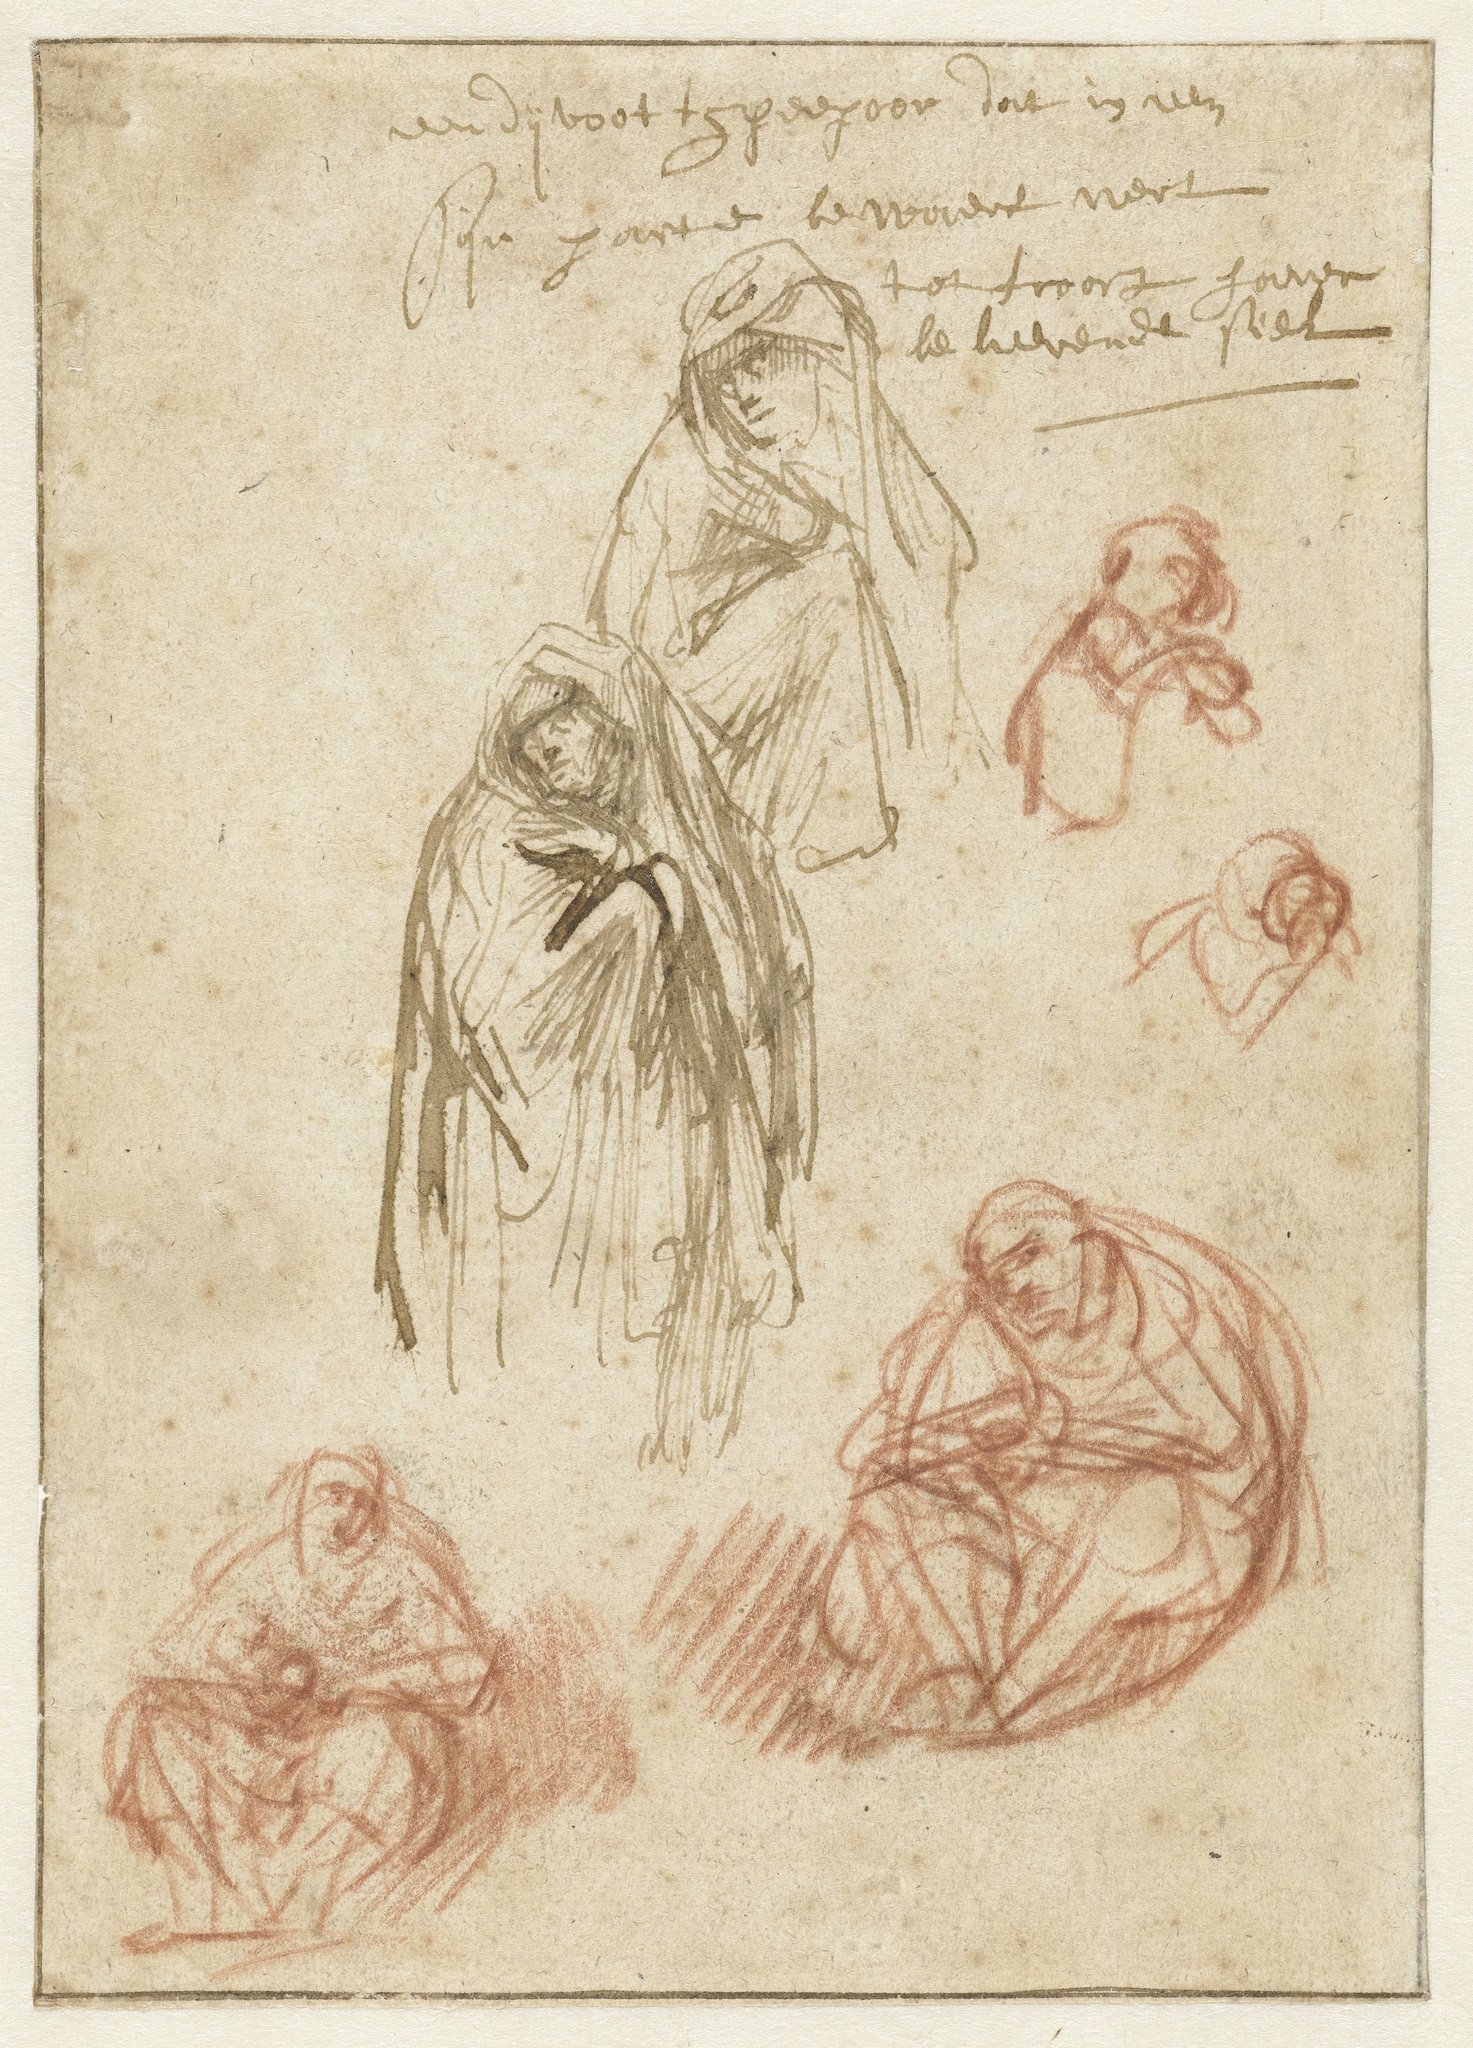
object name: drawing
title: Studies of the Mourning Magdalen and the Virgin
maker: rembrandt van rijn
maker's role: draughtsman, painter, print maker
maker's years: 1606-1669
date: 1635-1636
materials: chalk, paper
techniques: pen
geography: amsterdam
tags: (scenes from the life of) john the baptist and mary, crucified christ with mary, john, and mary magdalene, passion of christ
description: In the 1630s Rembrandt painted a series on the suffering of Christ, the Passion. Commissioned by Prince Frederick Henry, the project was discussed via the Prince’s secretary, Constantijn Huygens. Here Rembrandt tried out various poses for the figures of Mary Magdalene (in pen) and the Virgin (in red chalk) in The Entombment. As he later wrote to Huygens, he was seeking the ‘most natural emotions’ of the figures.